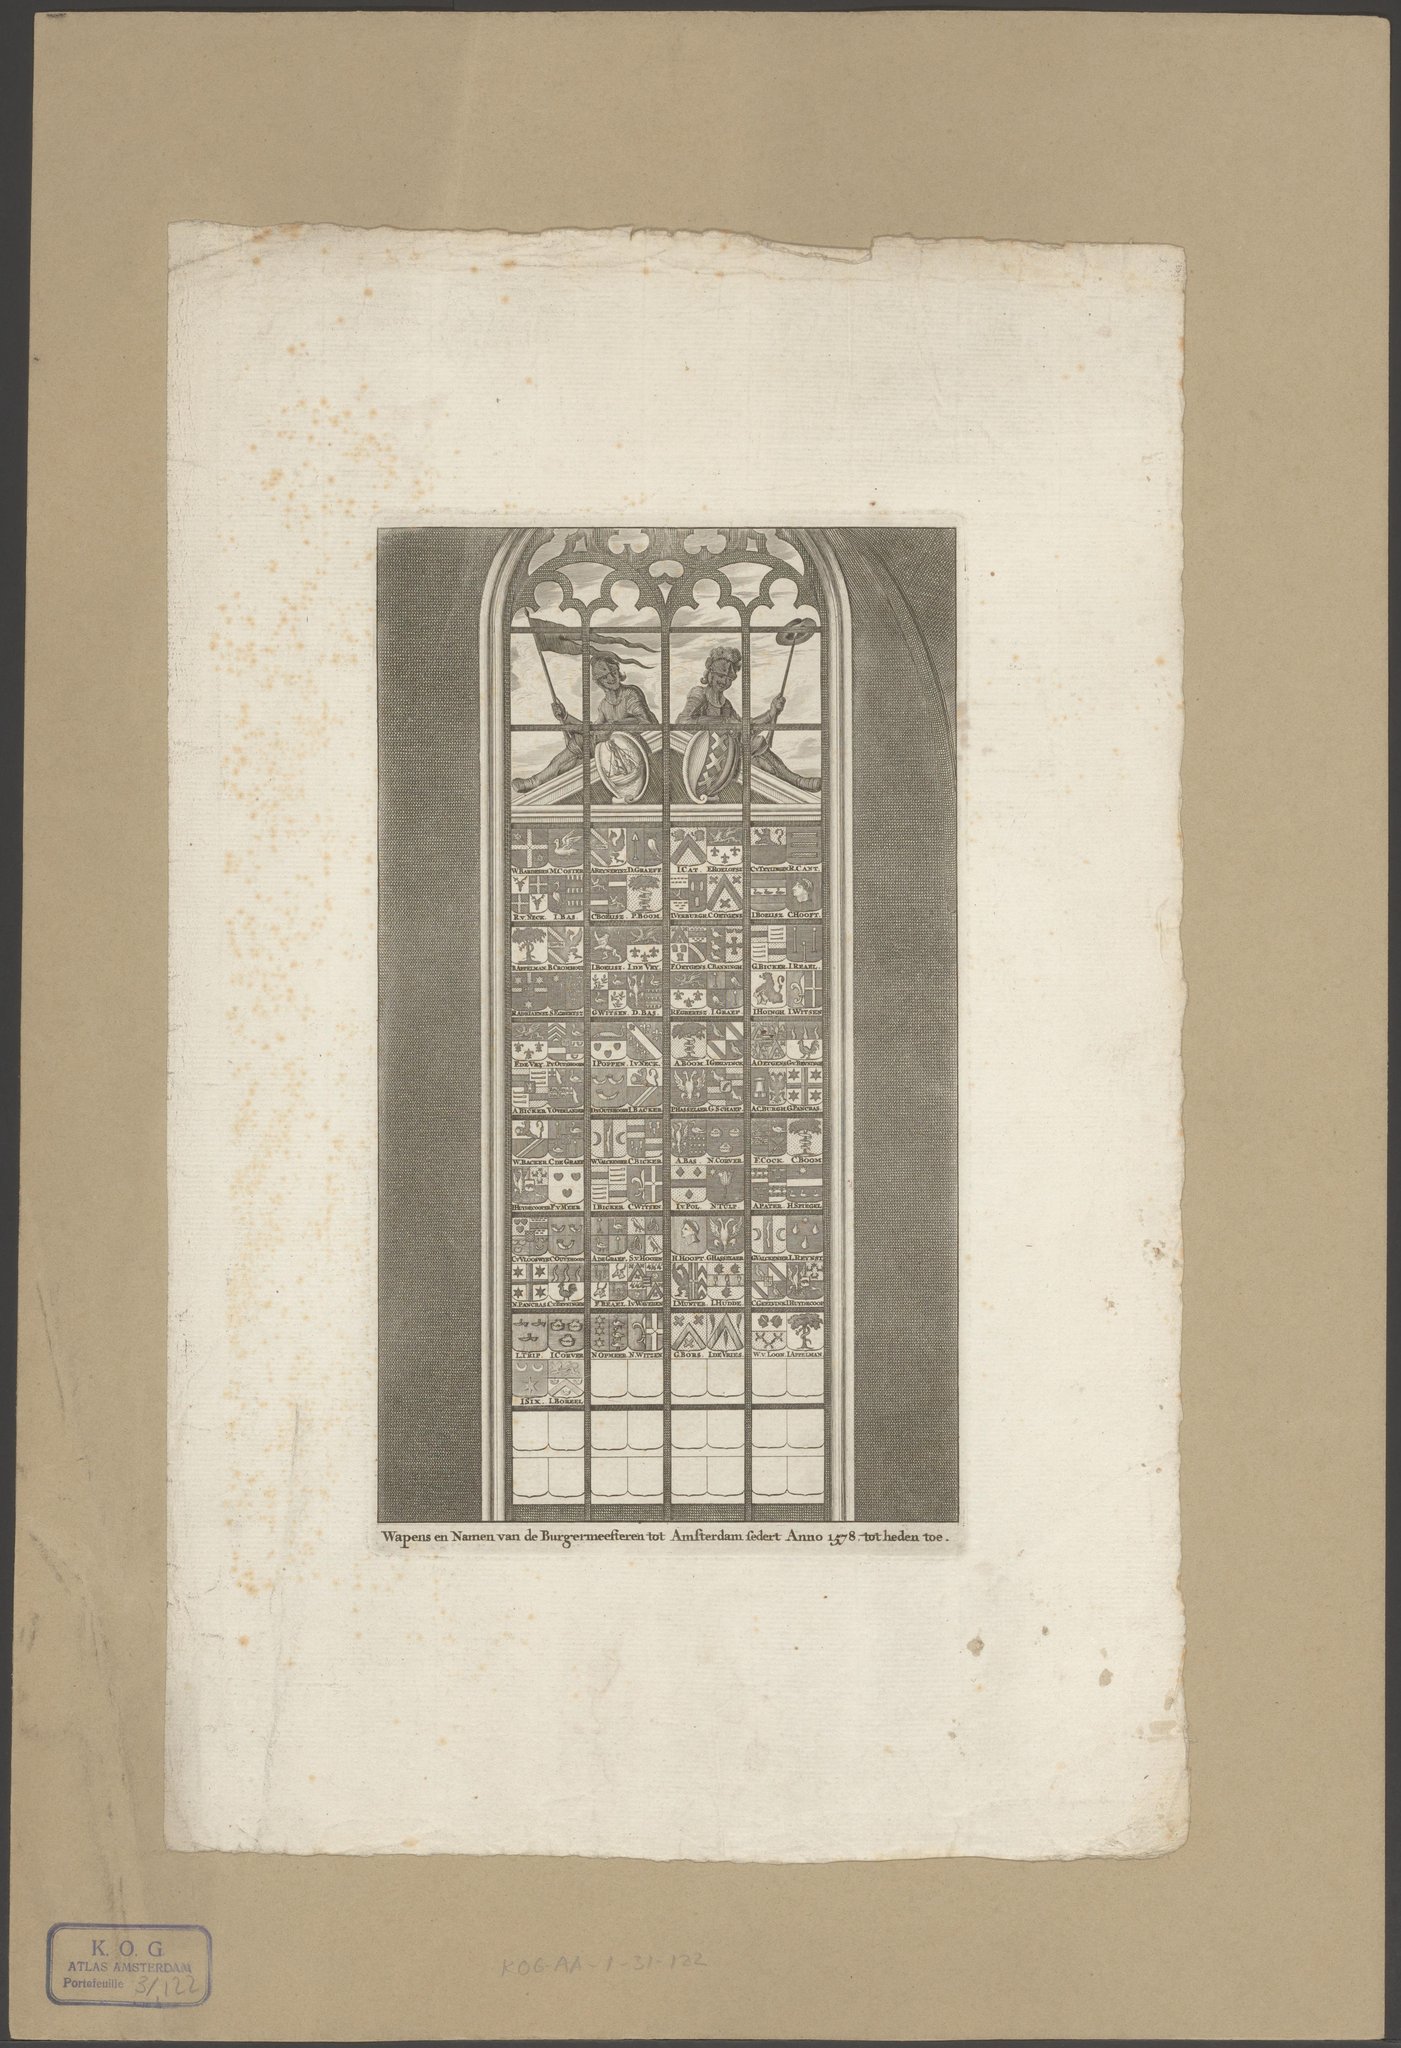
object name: print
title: Wapens en Namen van de Burgemeesteren tot Amsterdam sedert Anno 1578 tot heden toe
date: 1694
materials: paper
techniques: etching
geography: amsterdam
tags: device (as symbol of the state, etc.) (+ city; municipal), church-window, e.g. rose-window, armorial bearing, heraldry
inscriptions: collector's mark: ‘31.122’ Lugt 1641b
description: Glas-in-loodraam in de Noorderzijbeuk met de wapens van Amsterdamse burgemeesters, van 1578 tot 1757. Onderwerpsrubriek binnen de Atlas Amsterdam: Kerkwezen: Hervormde Gemeente: Oude Kerk van binnen.